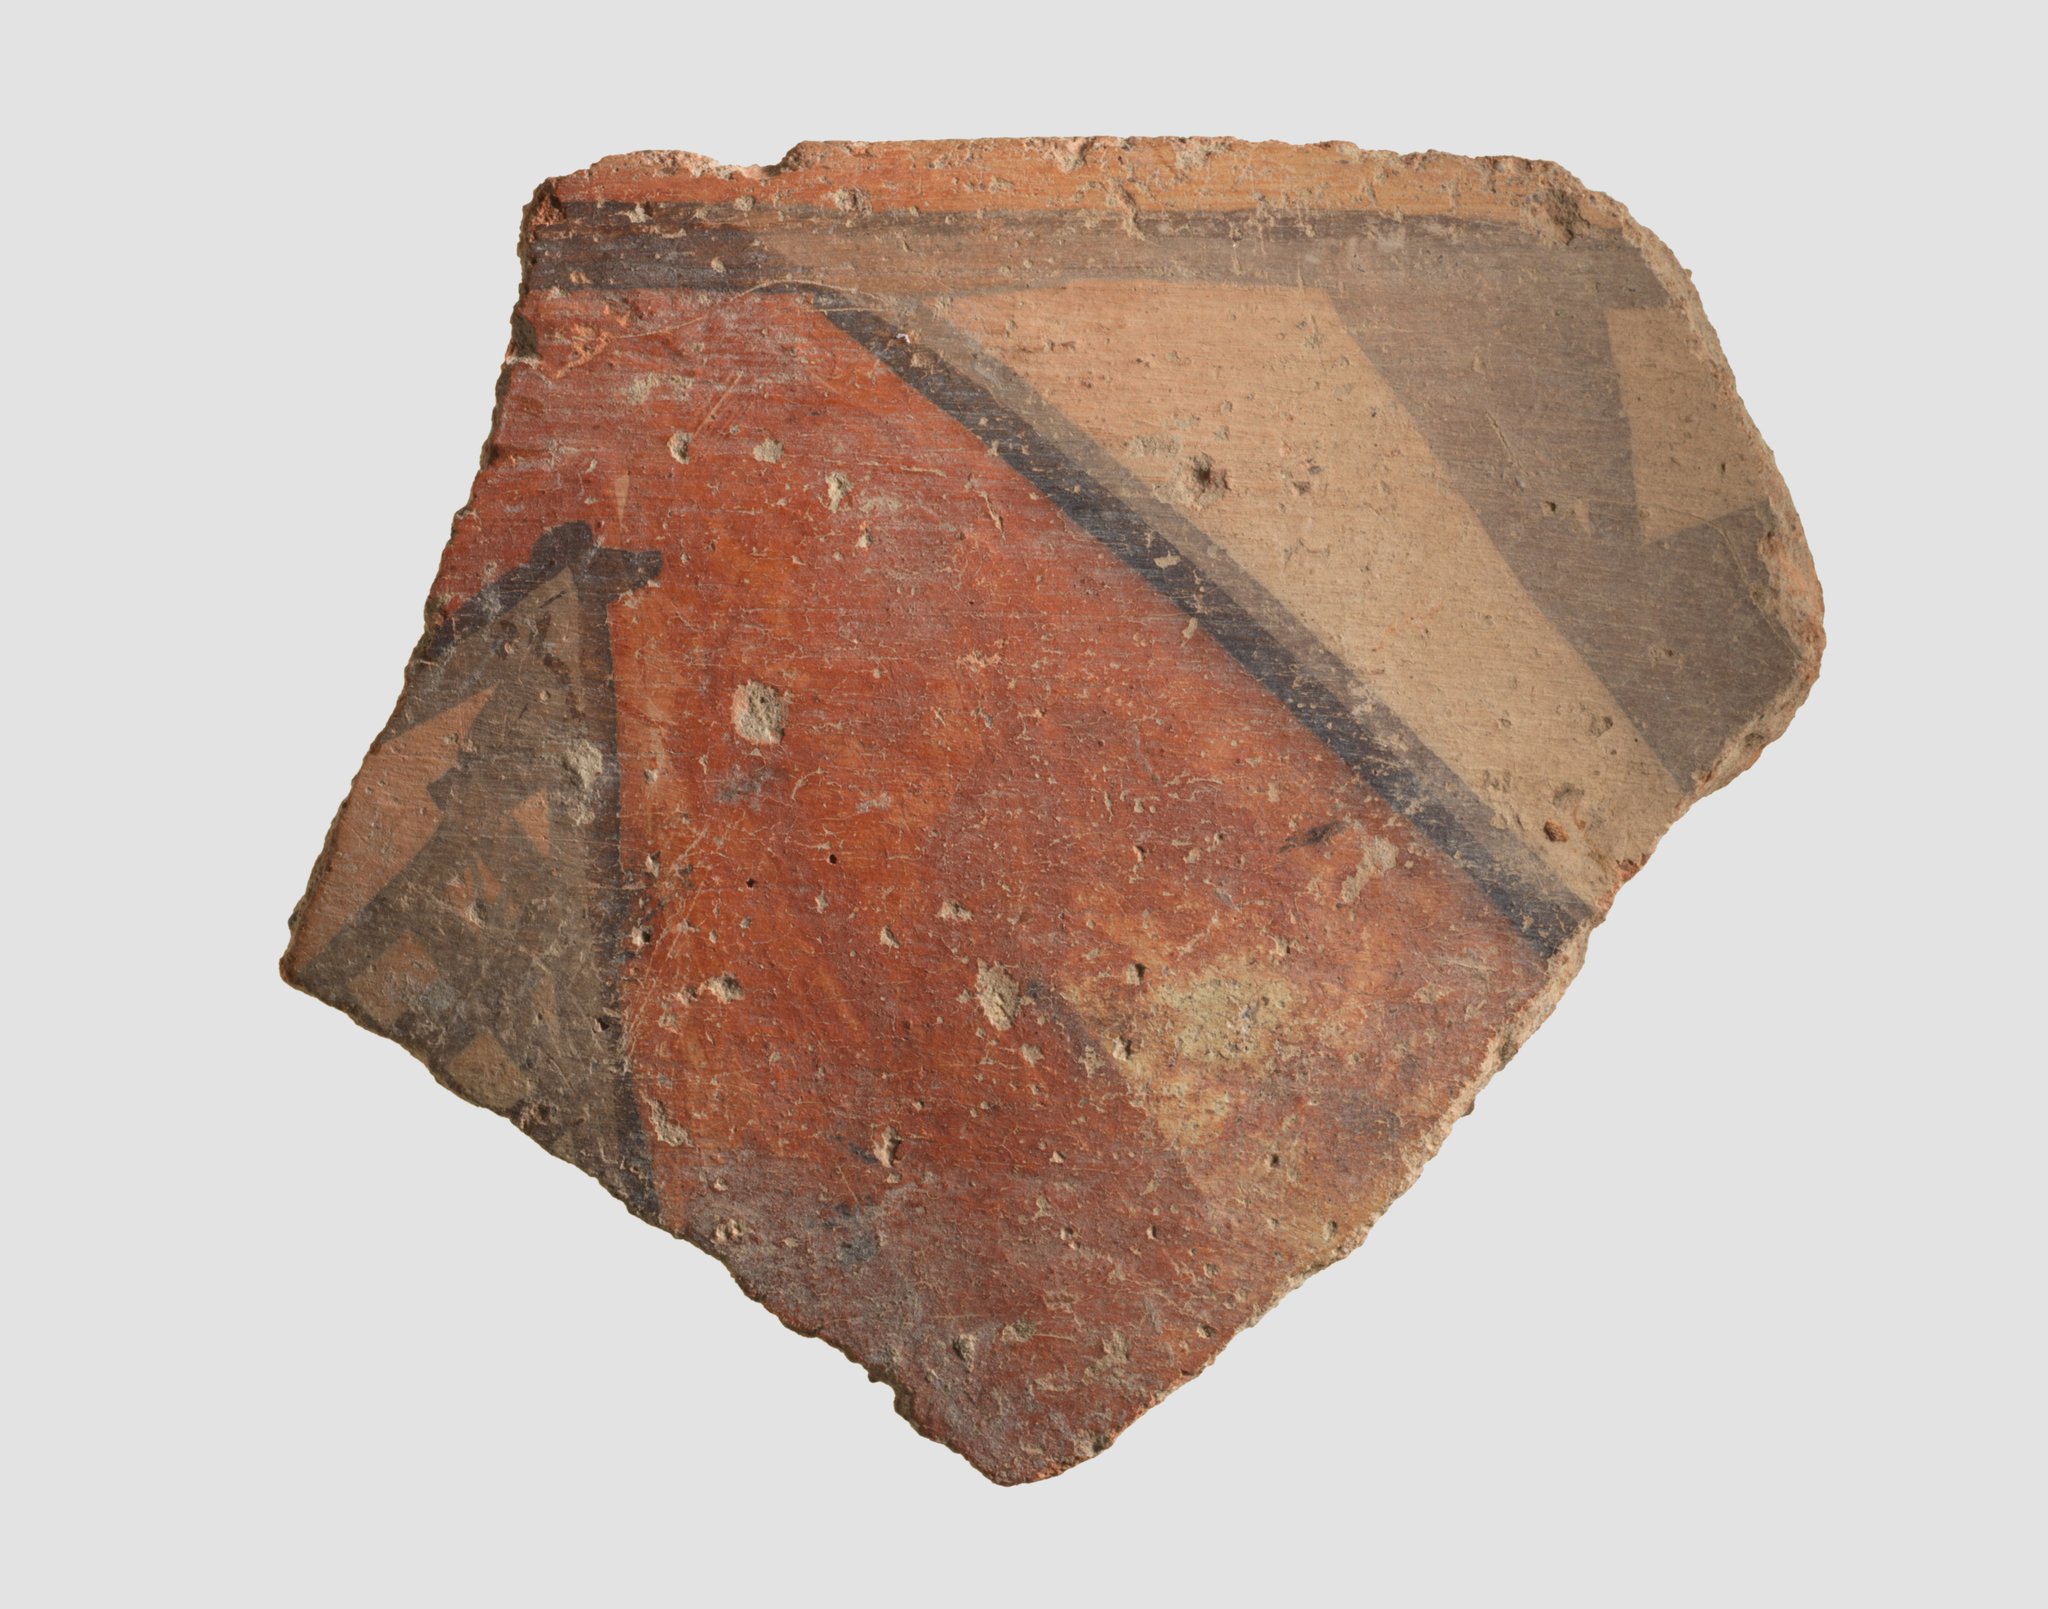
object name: sherd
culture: iranian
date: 3100-2700 BCE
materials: ceramic, paint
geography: iran